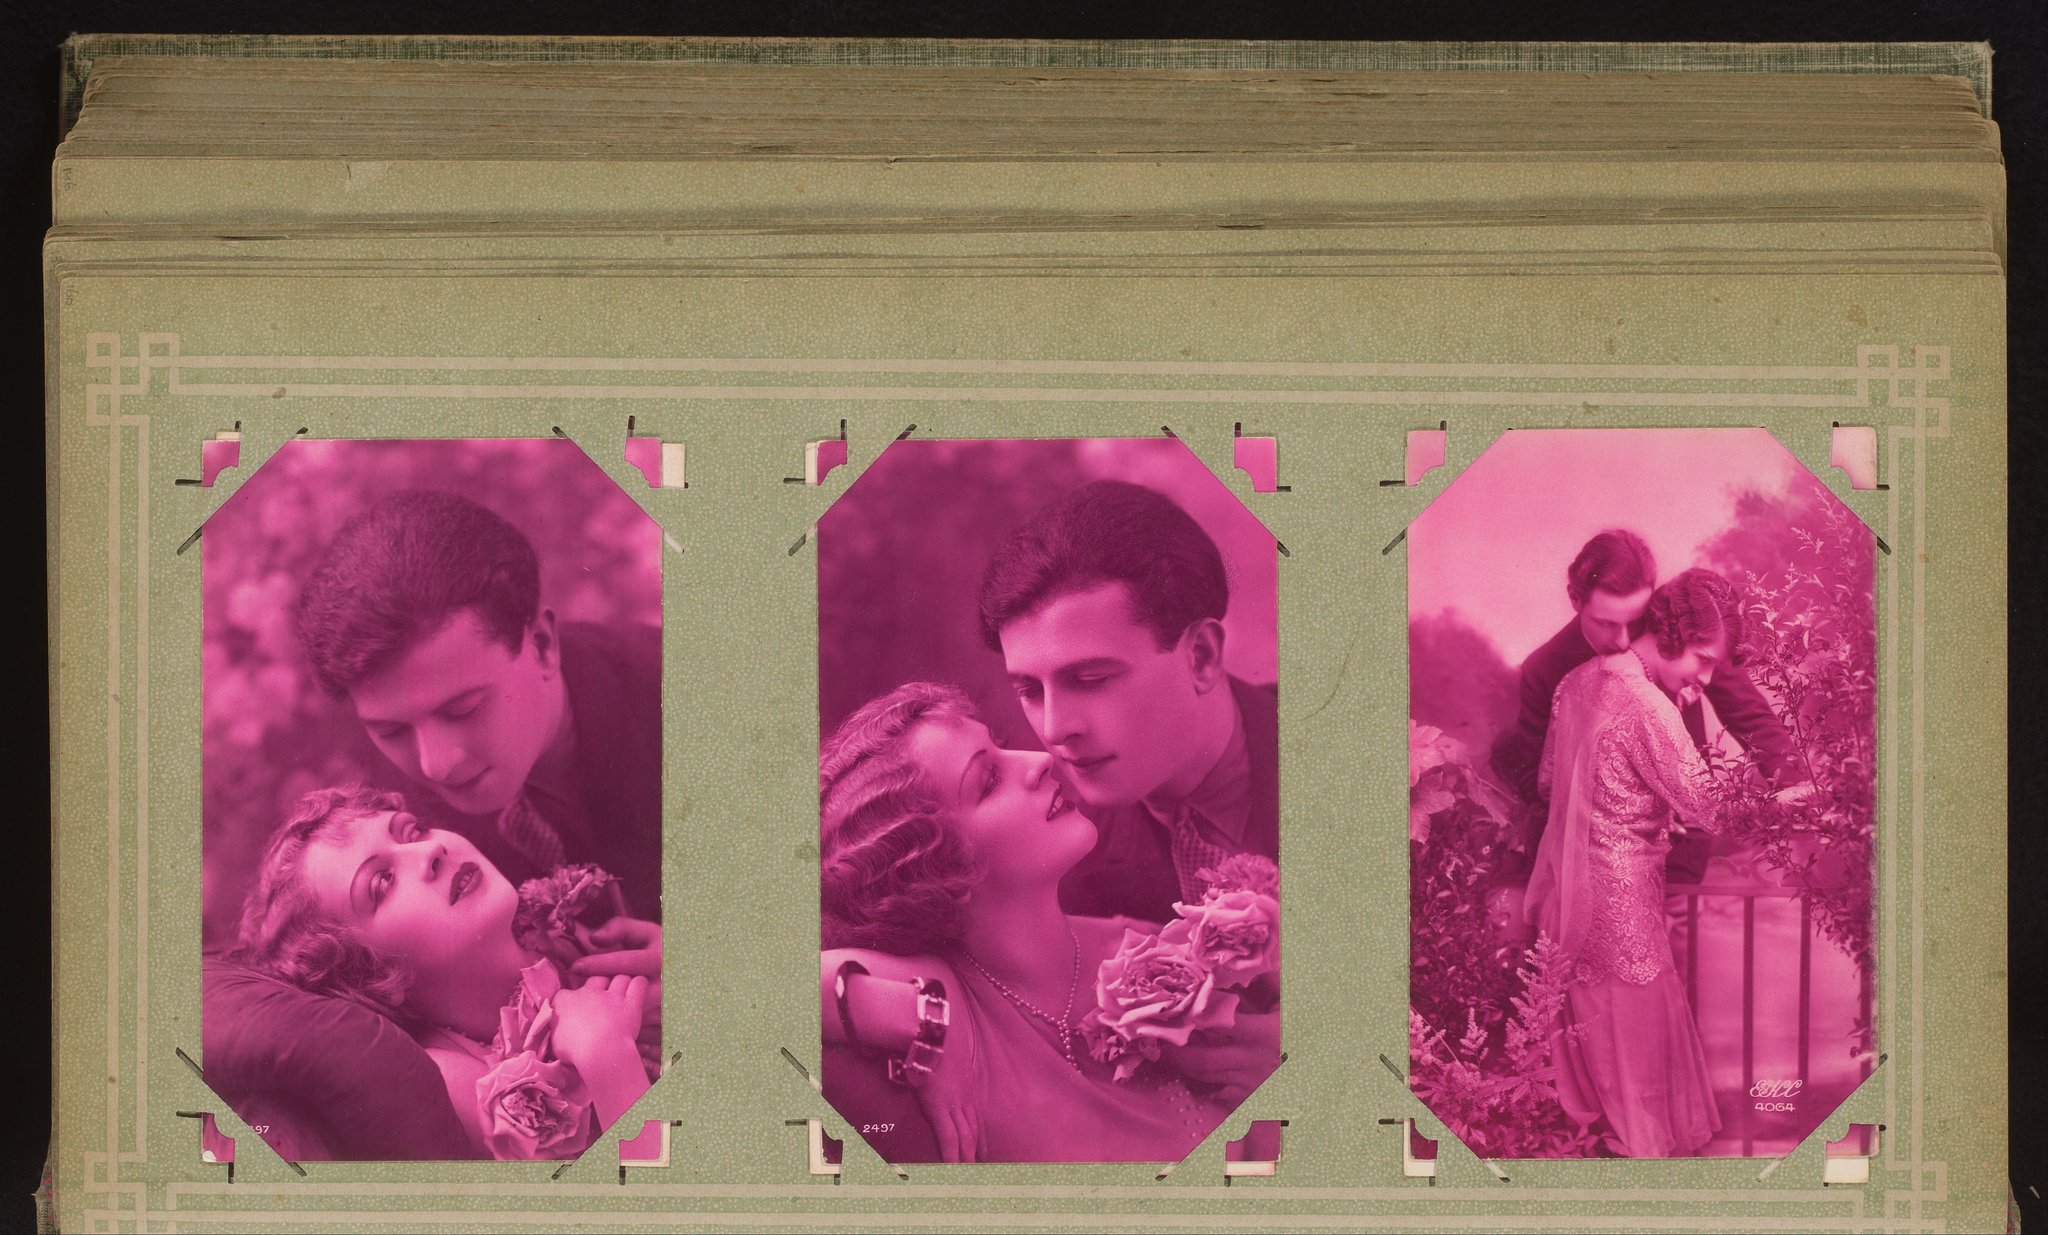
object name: ansichtkaart, prentbriefkaart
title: Drie portretten van een paar geliefden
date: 1900-1930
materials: cardboard, photographic support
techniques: gelatin silver print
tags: historical persons - bb - woman, historical persons, couple of lovers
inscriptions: monogram: ‘EKC’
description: Deze foto's maken deel uit van een album.